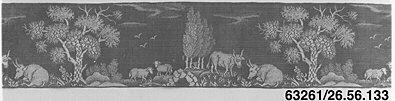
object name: ribbon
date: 1834-1866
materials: silk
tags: animals,trees